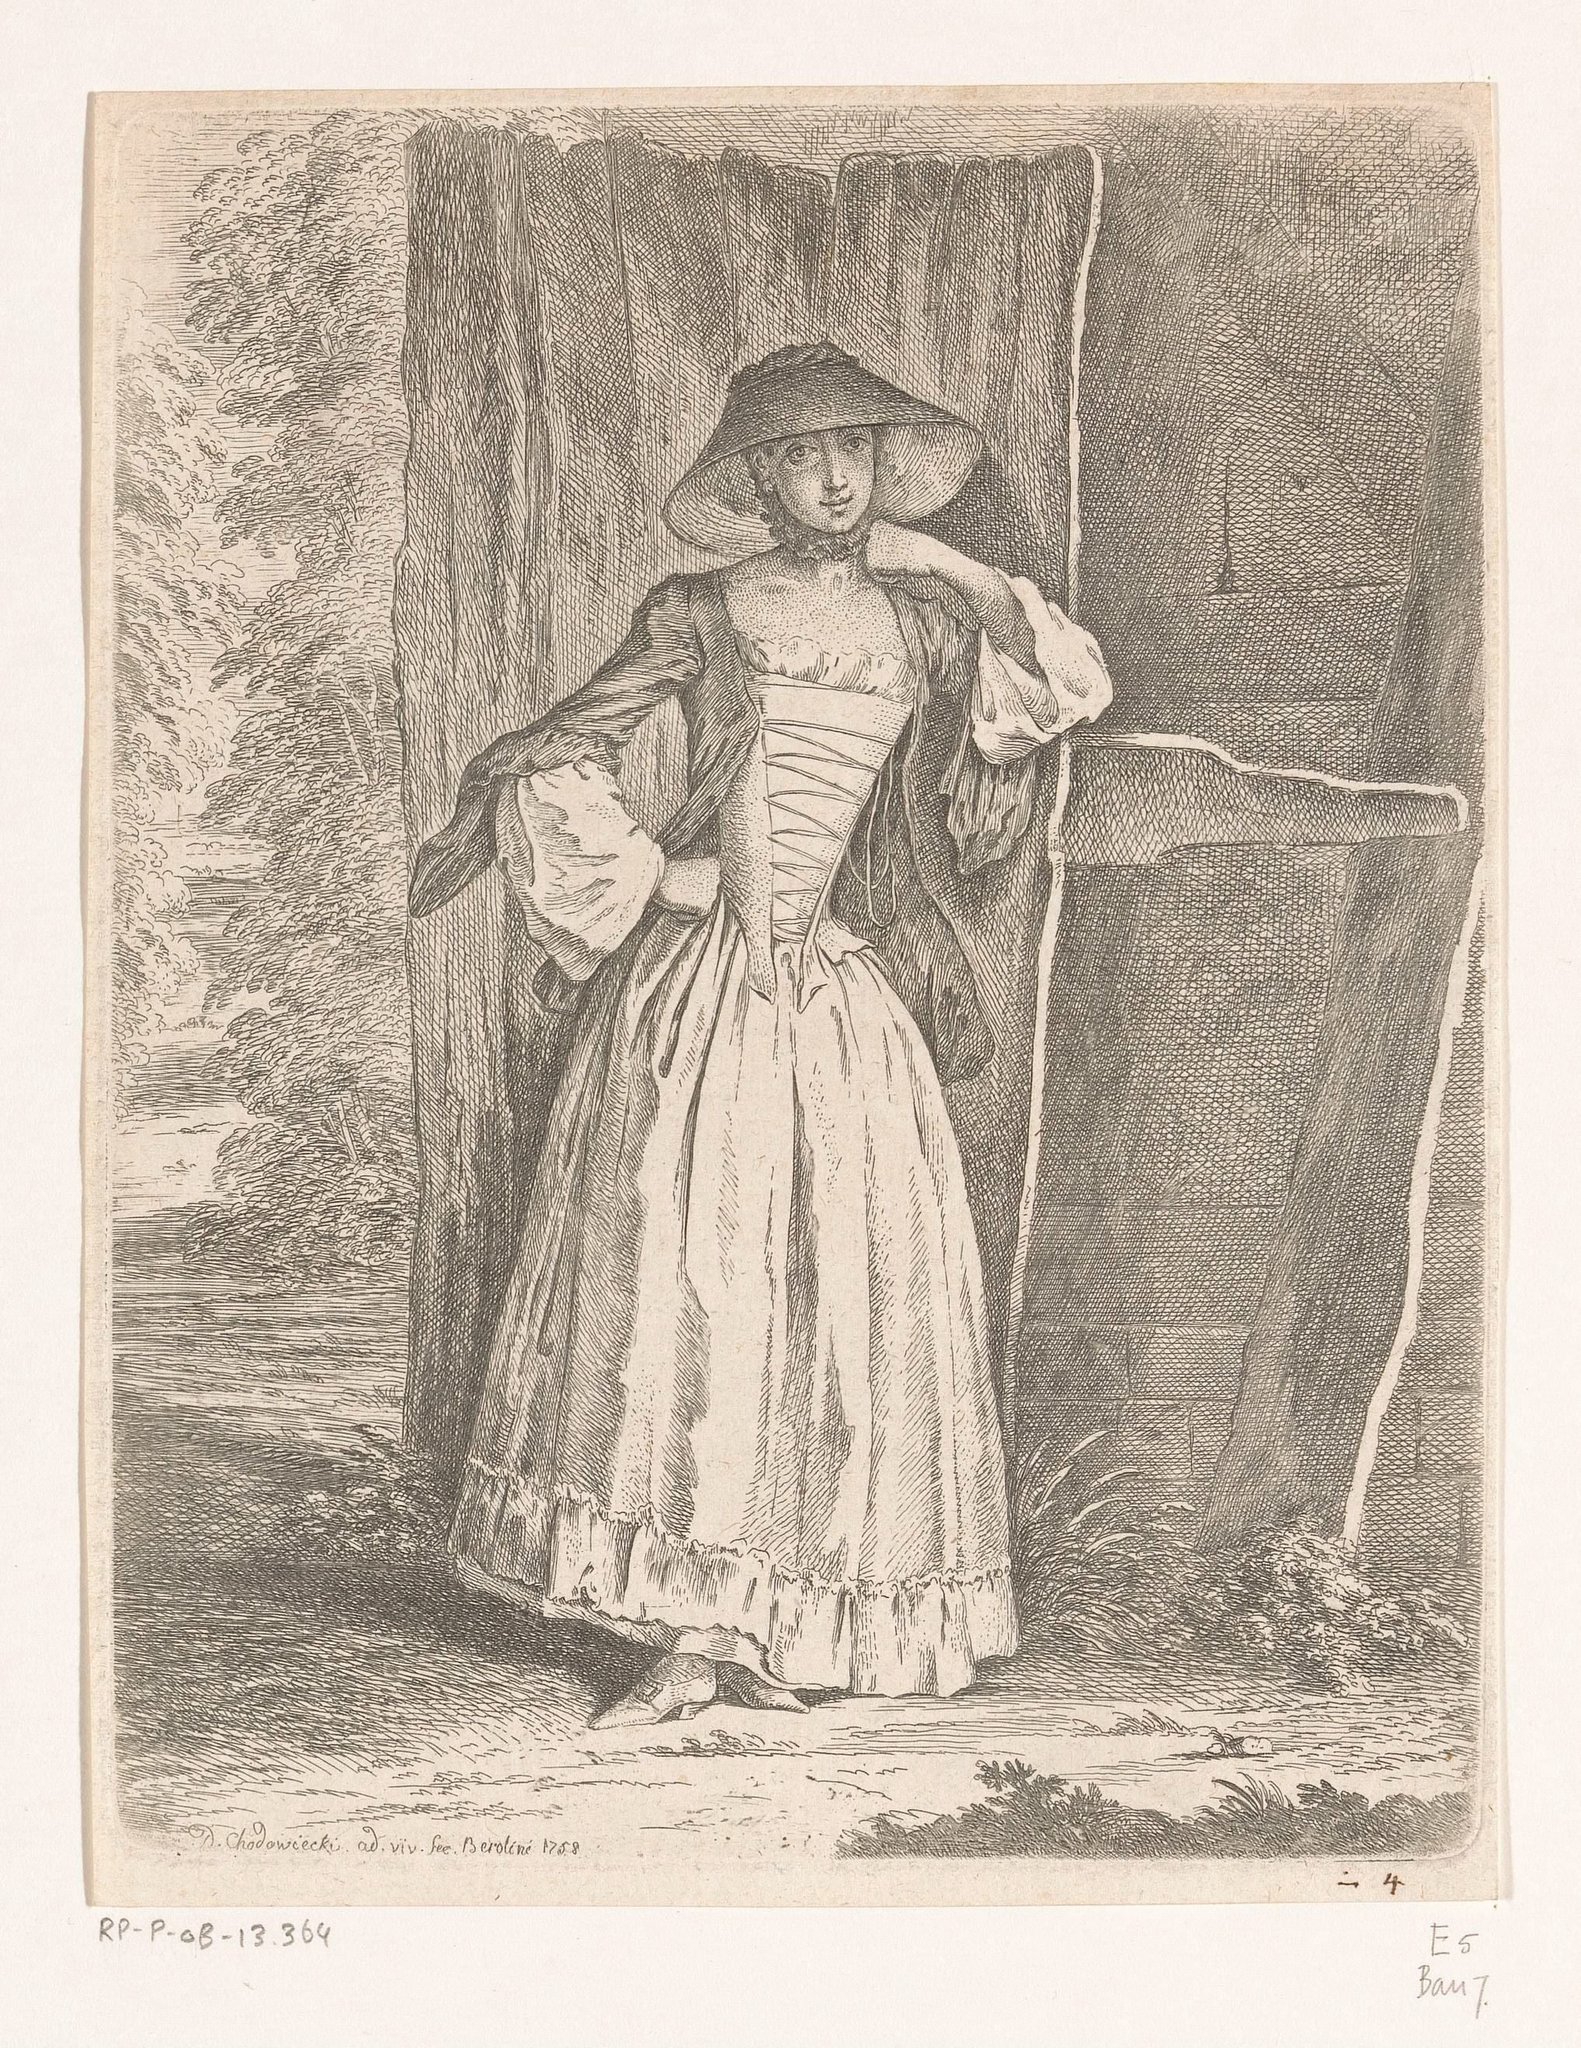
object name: print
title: Staande dame (Demoiselle Quantin)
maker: daniel nikolaus chodowiecki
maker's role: draughtsman, print maker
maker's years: 1726-1801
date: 1758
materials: paper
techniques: etching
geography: berlin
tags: adolescent, young woman, maiden, gate, entrance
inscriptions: inscription: ‘- 4’, collector's mark: Lugt 700, collector's mark: Lugt 240